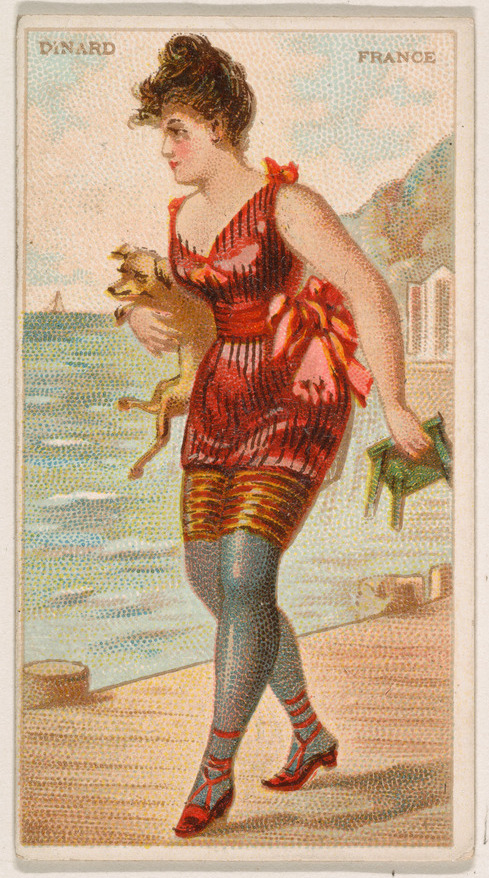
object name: print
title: Dinard, France, from the Surf Beauties series (N232), issued by Kinney Bros.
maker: kinney brothers tobacco company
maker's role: publisher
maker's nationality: american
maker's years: 1869-2011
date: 1889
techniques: color lithograph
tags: profiles,women